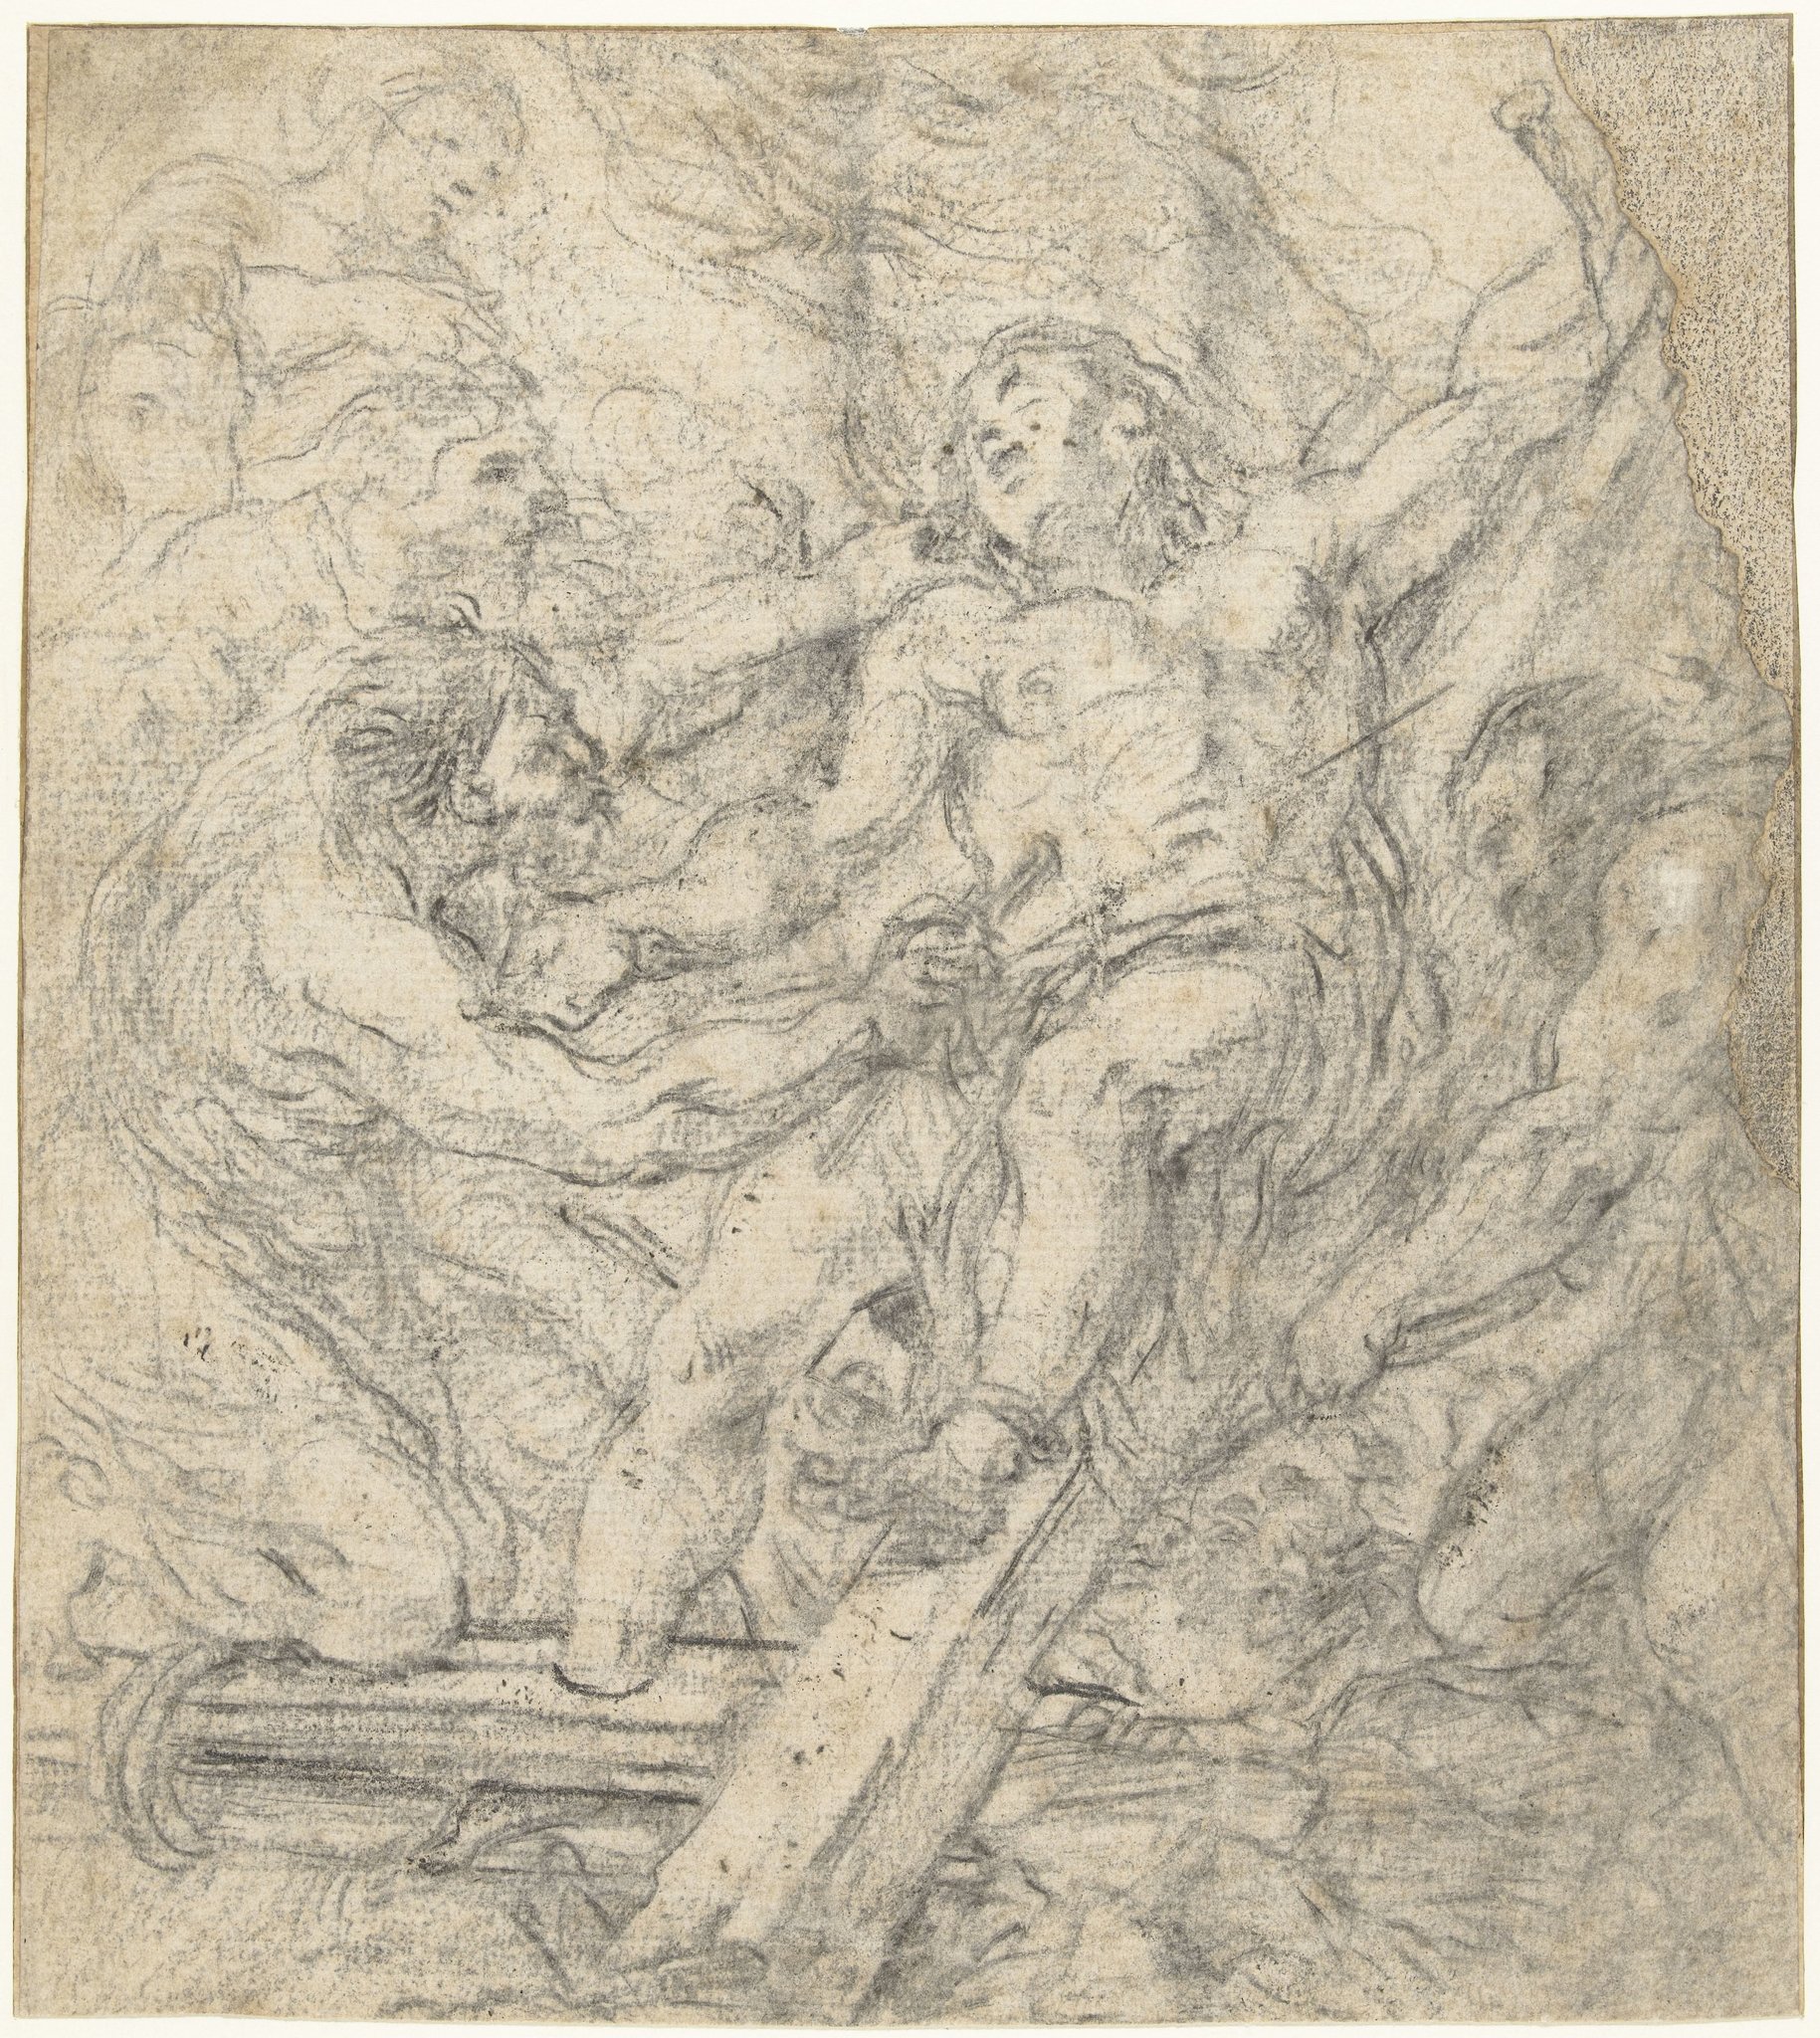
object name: drawing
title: Marteling van een heilige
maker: mattia preti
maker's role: draughtsman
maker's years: 1613-1699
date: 1656-1660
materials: chalk, paper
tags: saints